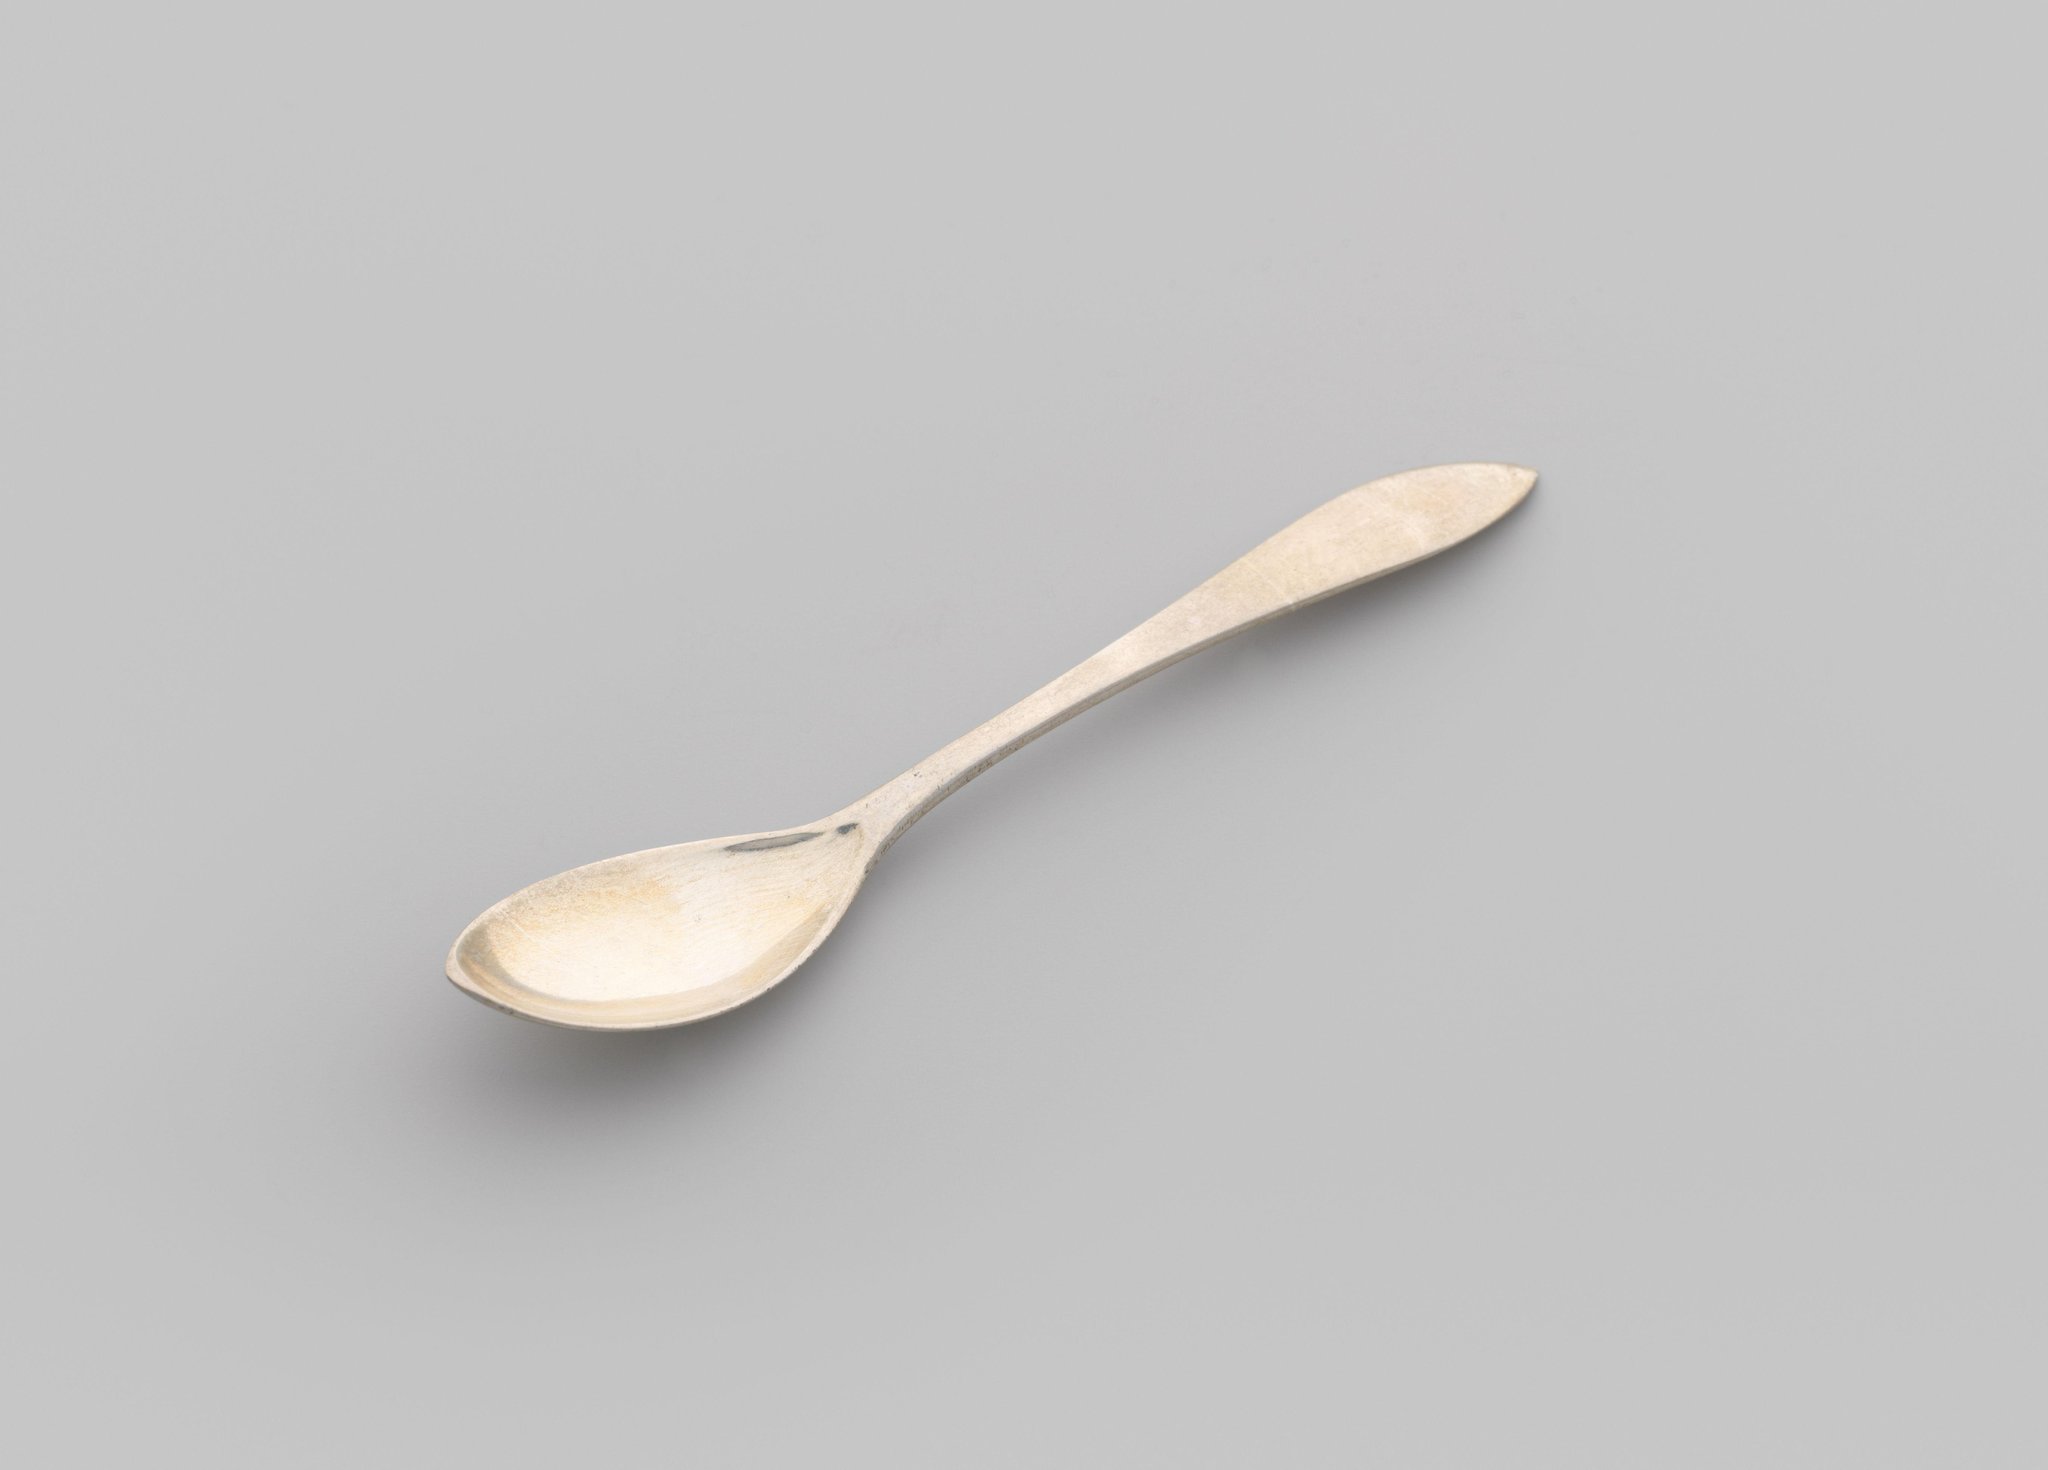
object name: teaspoon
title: Theelepel met spits ovale bak en platte, gebogen steel, die zich verbreedt naar het spitse uiteinde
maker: hendrik overhulsman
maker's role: silversmith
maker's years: 1756-1836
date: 1804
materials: silver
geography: amsterdam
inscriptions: town mark, maker's mark, date letter: ‘V’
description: De spits ovale bak is door middel van enkel lof verbonden met de platte, gebogen steel, die zich verbreedt naar het spitse uiteinde.